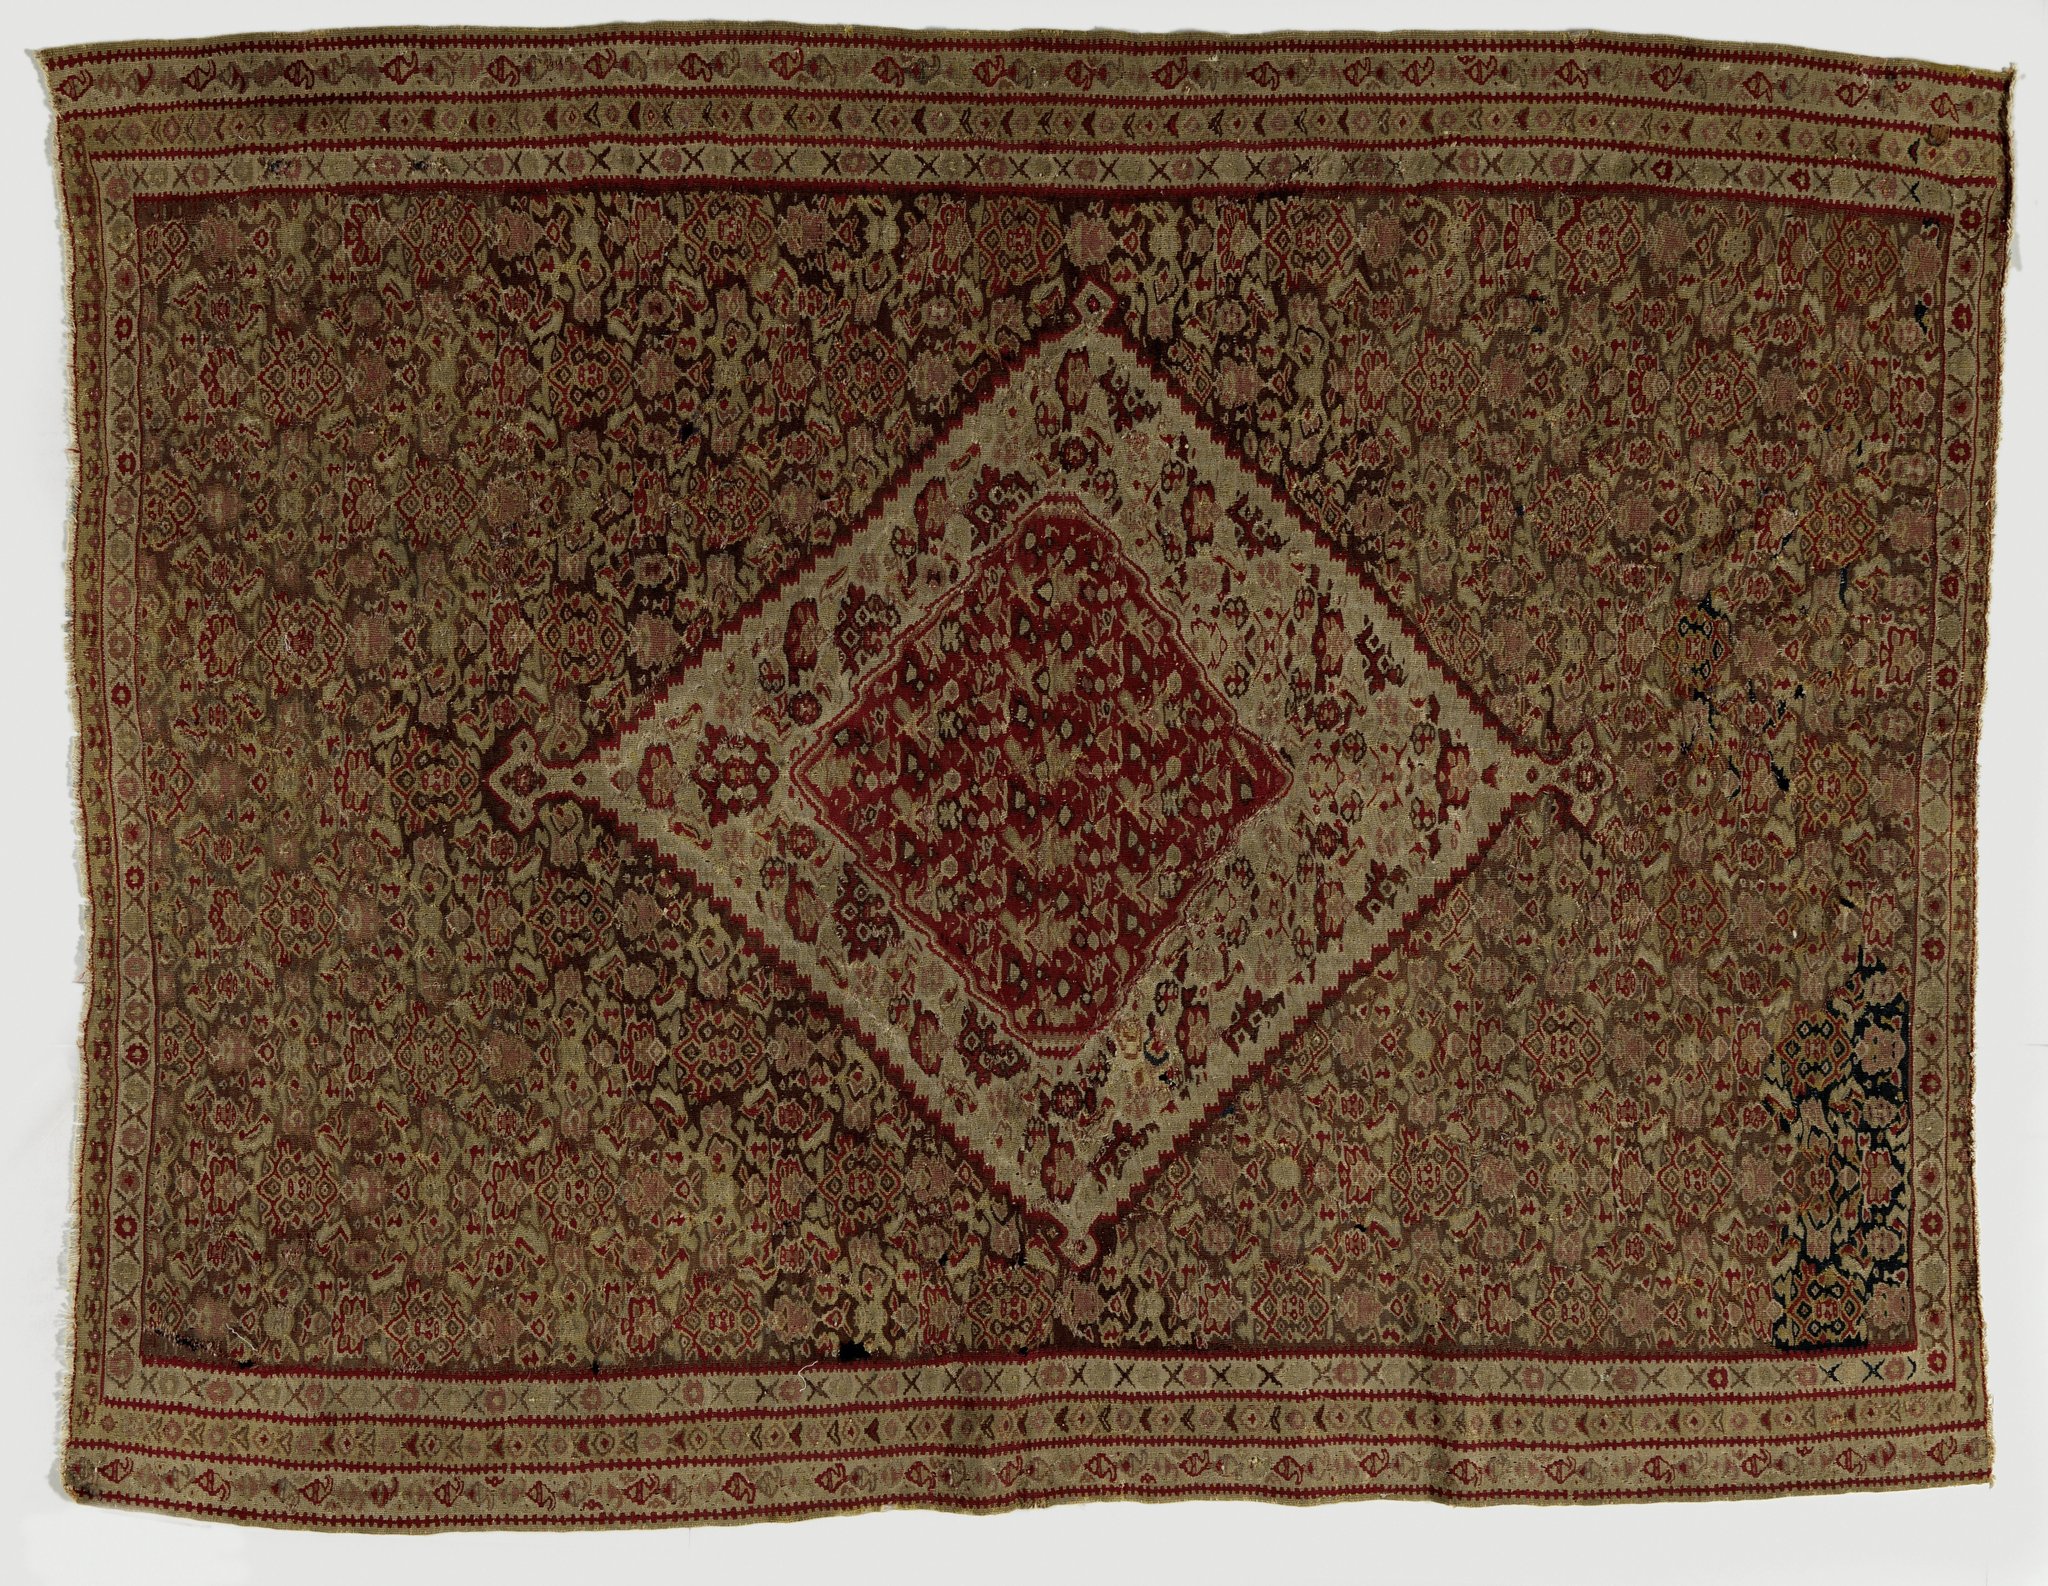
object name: oriental rug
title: Medaillonkleed overdekt met florale motieven, een Heratipatroon, op blauwe grond. Concentrische rode ruit met floraal patroon en vogelachtige ornamenten. Drievoudige rand.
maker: Anonymous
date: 1800-1950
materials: cotton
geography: kurdistan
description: Oosters tapijt, medaillonkleed in kelim-techniek. Het blauwe veld is overdekt met florale motieven, een Herati-patroon. Hetzelfde Herati-patroon komt terug in het witte medaillon; de concentrische rode ruitvorm heeft een floraal patroon met vogelachtige ornamenten. Drievoudige rand.